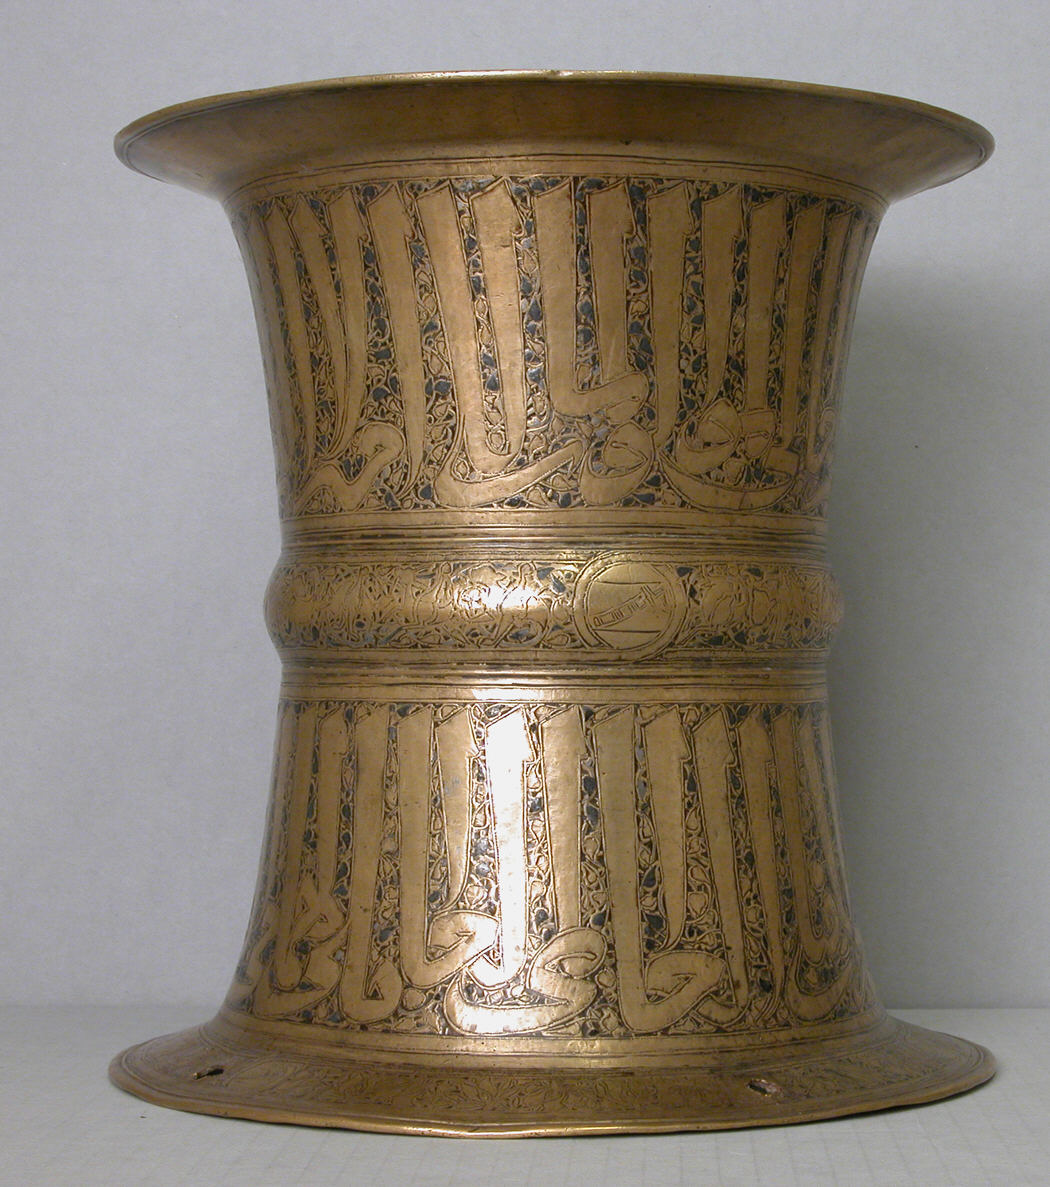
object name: stand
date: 1301-1350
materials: brass, silver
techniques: inlay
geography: egypt or syria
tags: arabic